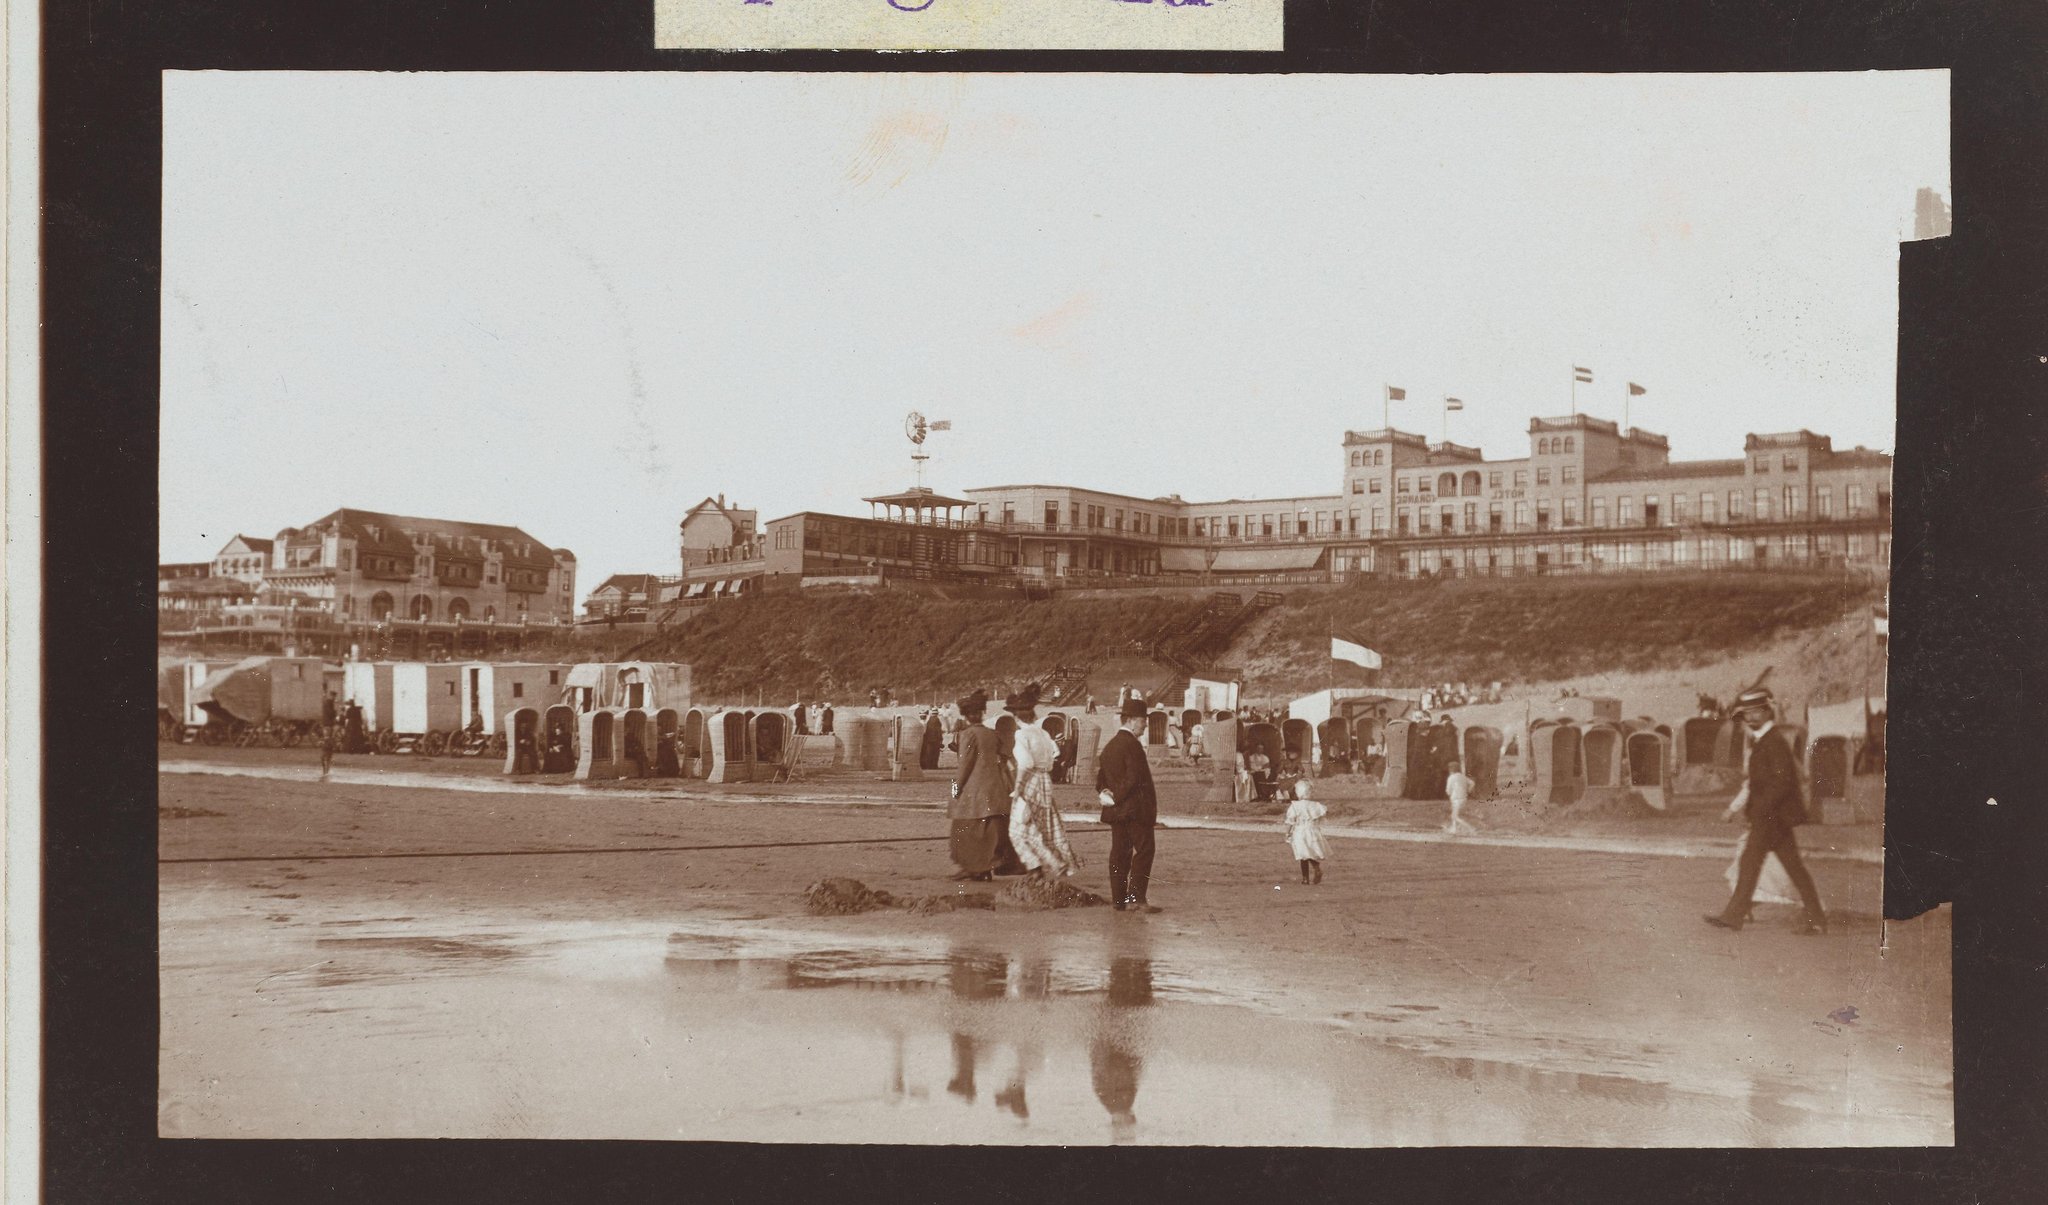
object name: photograph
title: Het strand in Zandvoort met strandstoelen en Hotel d'Orange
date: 1900-1905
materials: photographic support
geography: zandvoort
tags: beach (as place of recreation)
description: Mensen en strandstoelen op het strand. Op de duinen het Hotel d'Orange. Dit hotel werd in 1943 afgebroken door de Duitsers vanwege de Atlantikwal. M.b. opschrift 'Spiegelbild'.